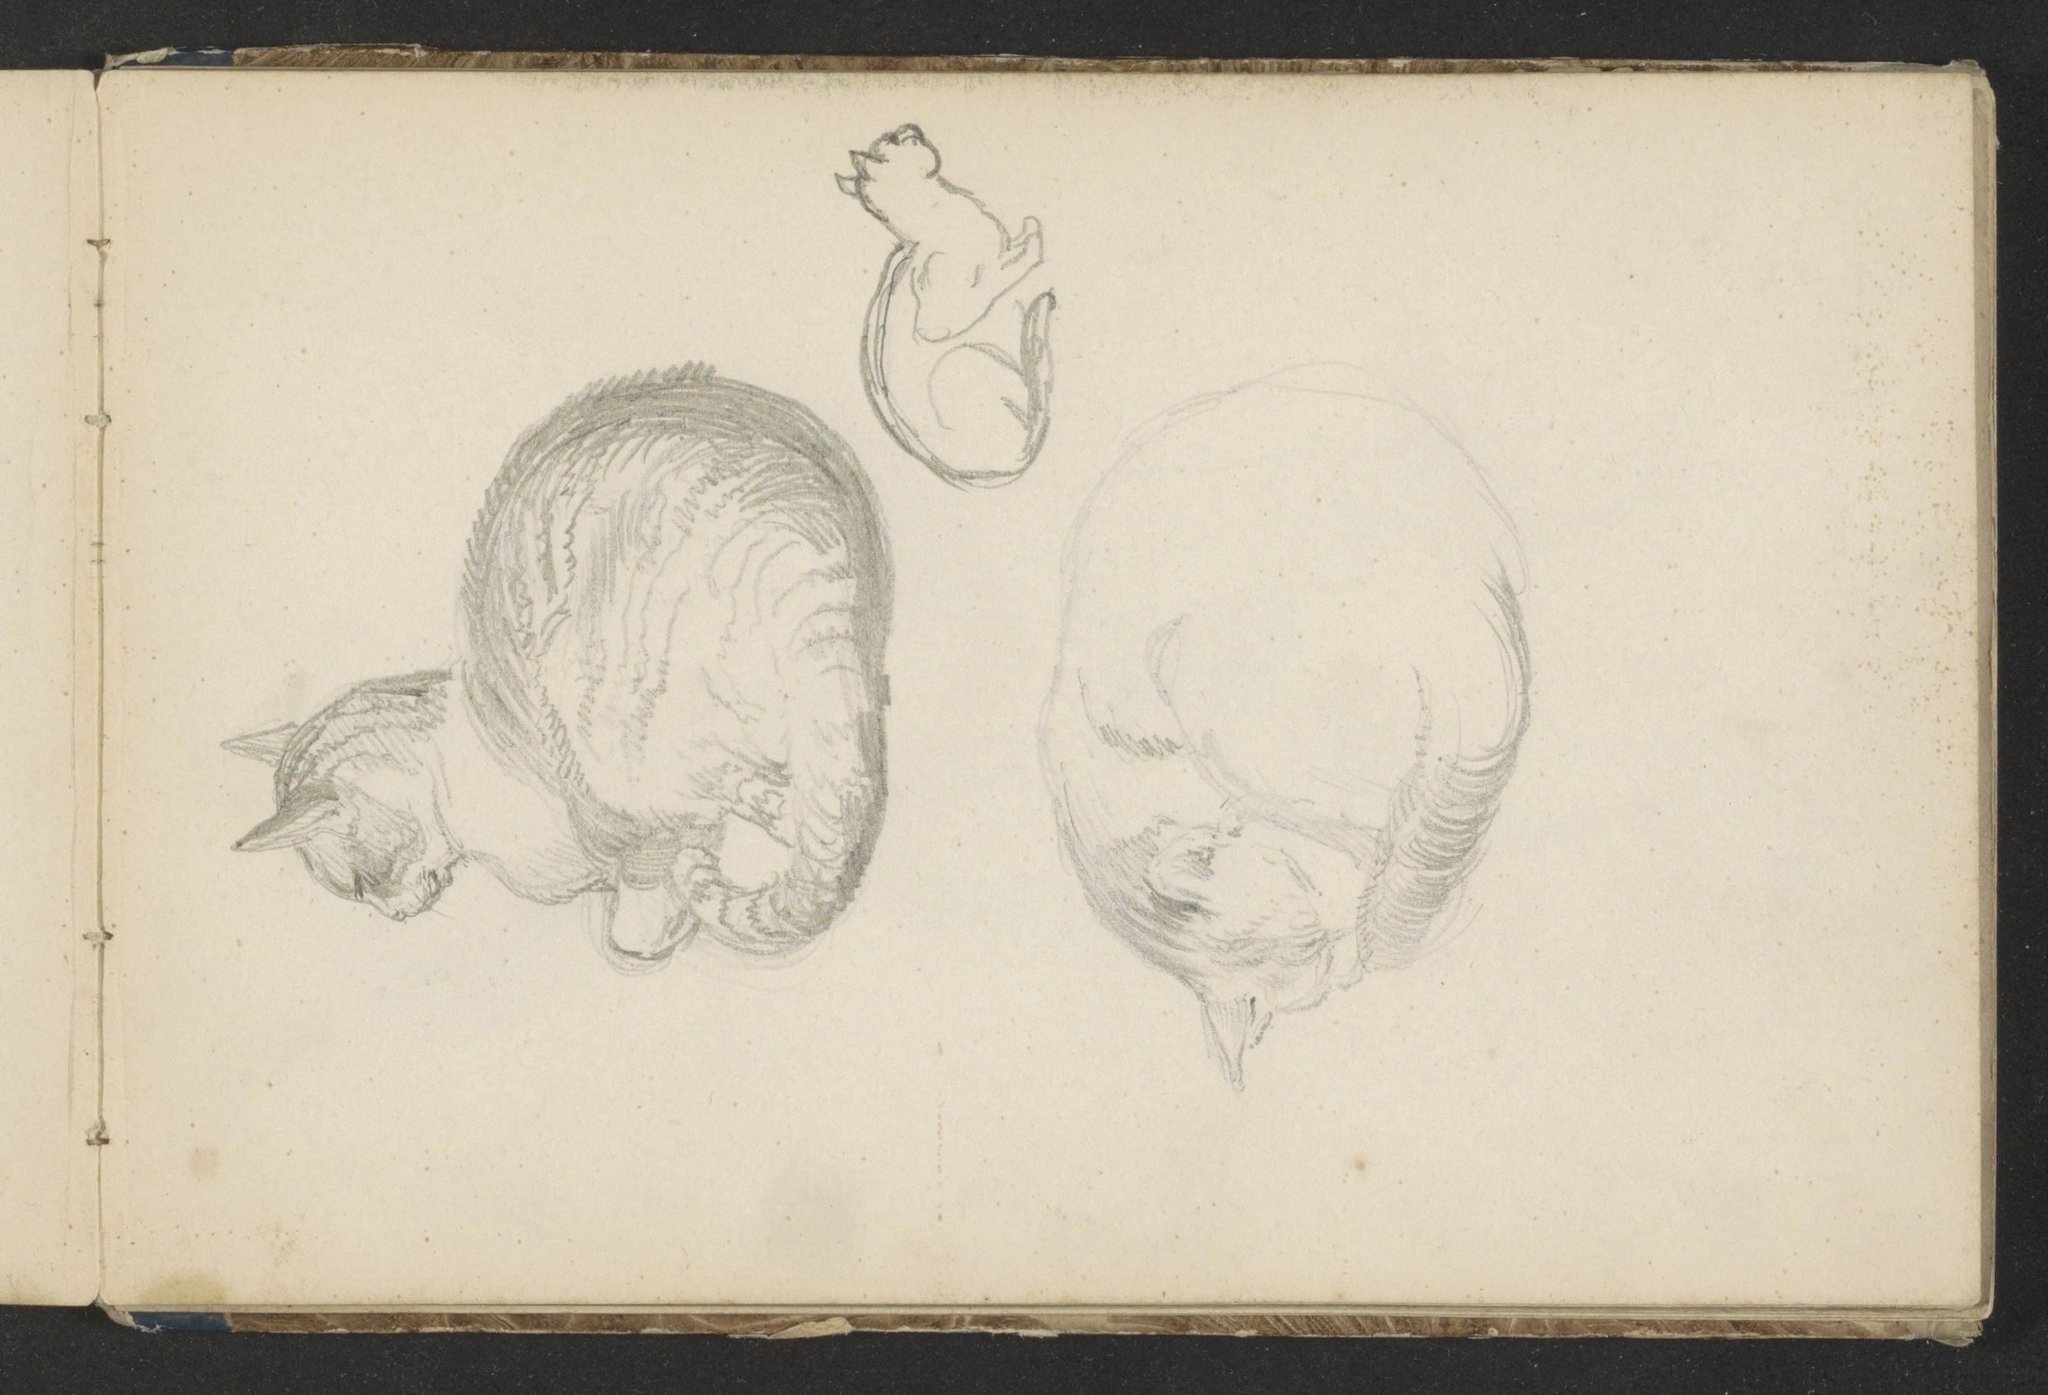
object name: sketchbook leaf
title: Studieblad met katten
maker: Anonymous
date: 1841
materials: paper, pencil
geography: rome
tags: cat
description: Blad 5 recto uit een schetsboek met 33 bladen.